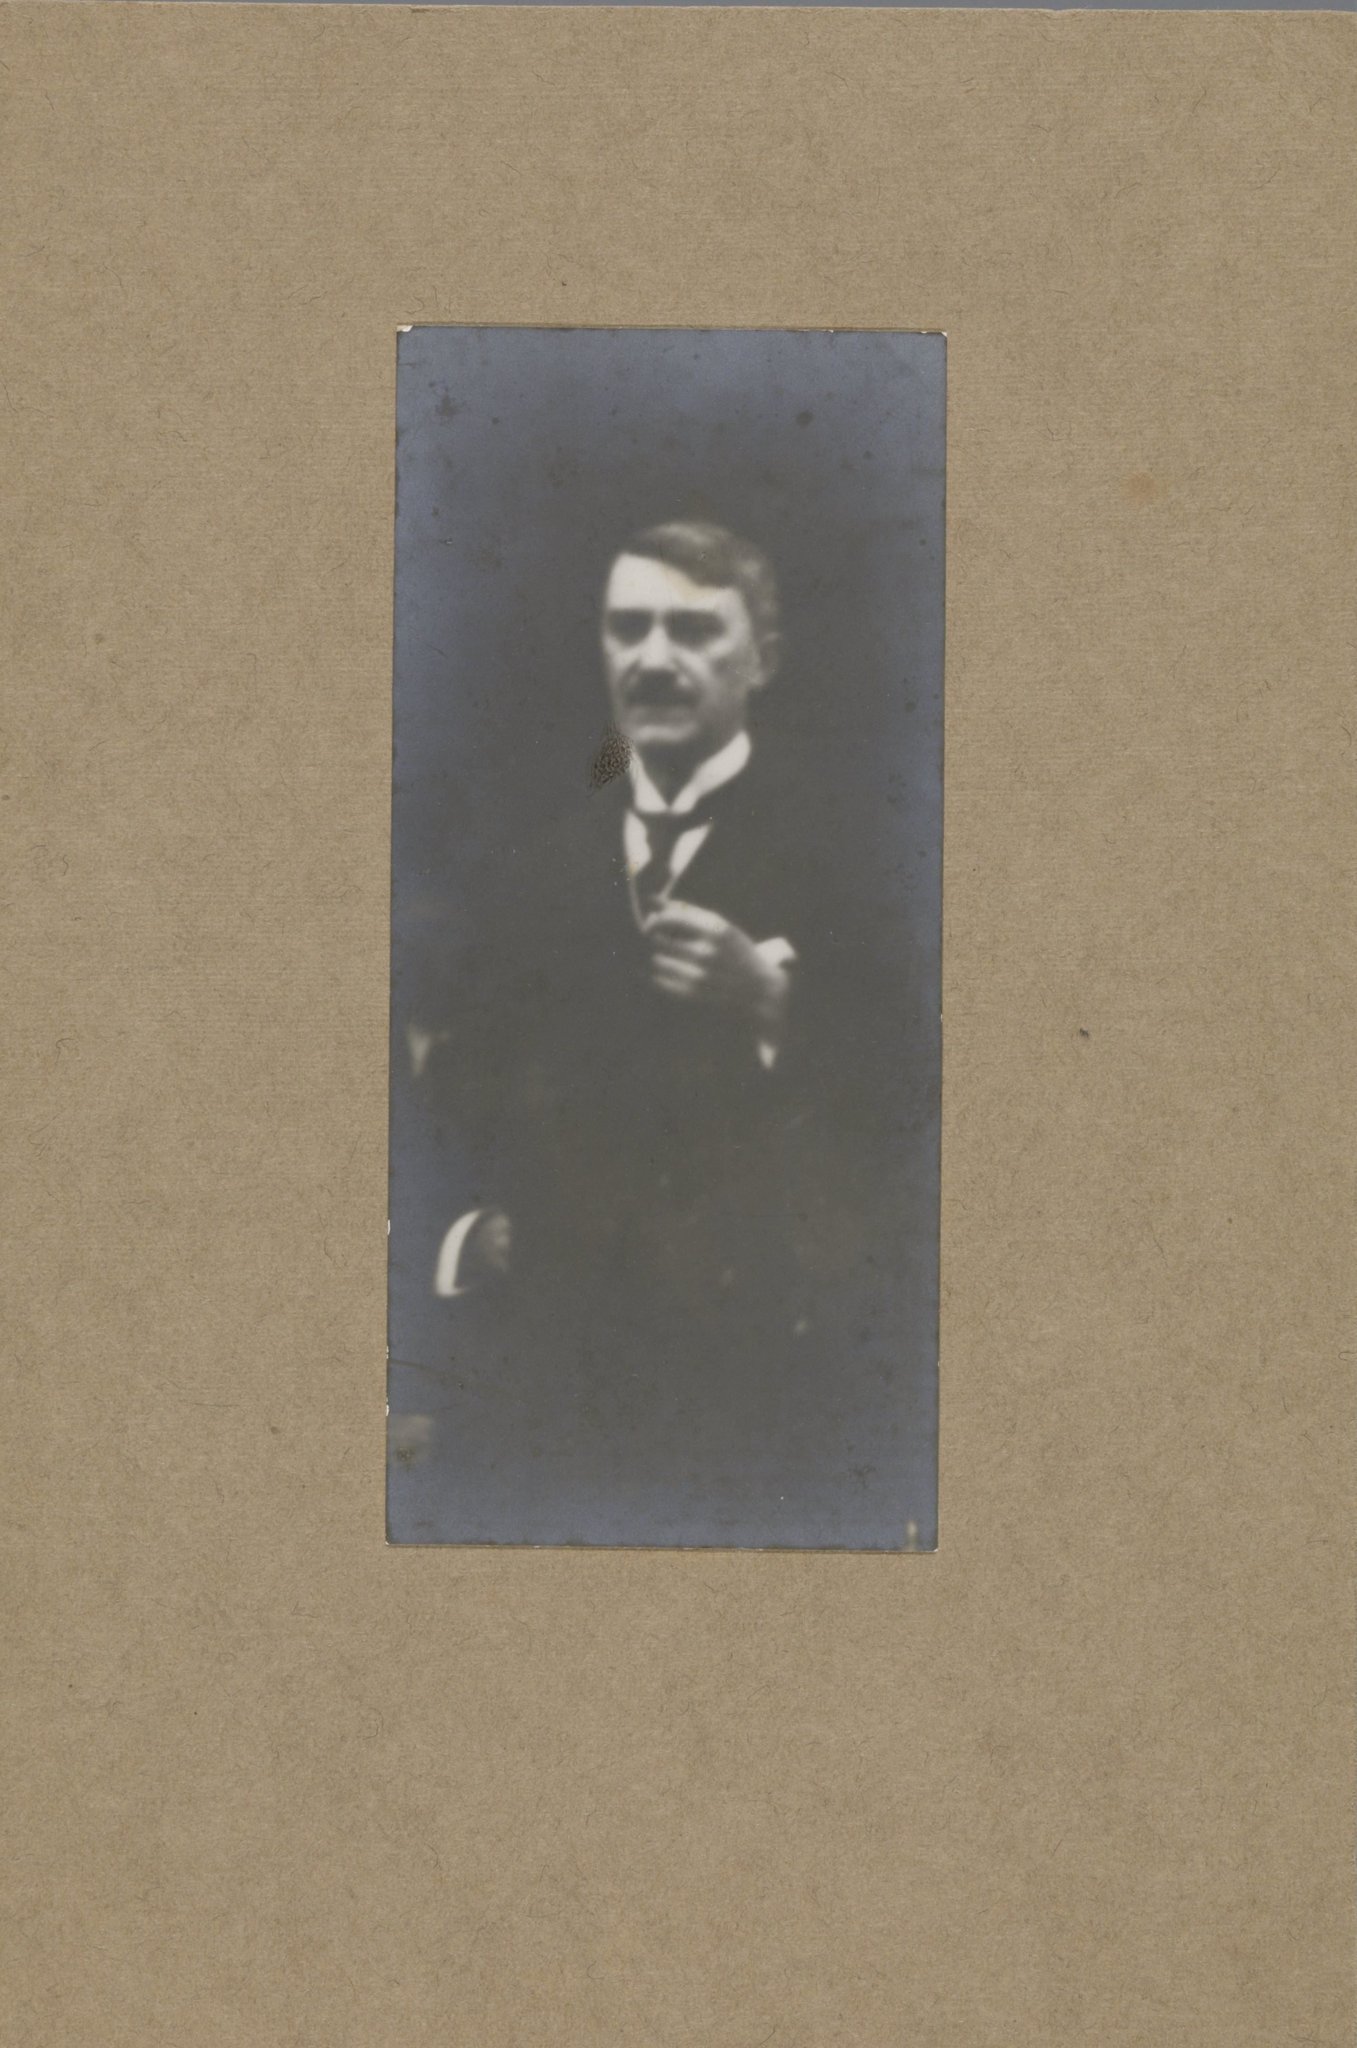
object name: photograph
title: Willem Witsen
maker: Anonymous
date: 1860-1915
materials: paper, photographic support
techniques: gelatin silver print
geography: amsterdam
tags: amsterdam, painter, draughtsman, willem witsen